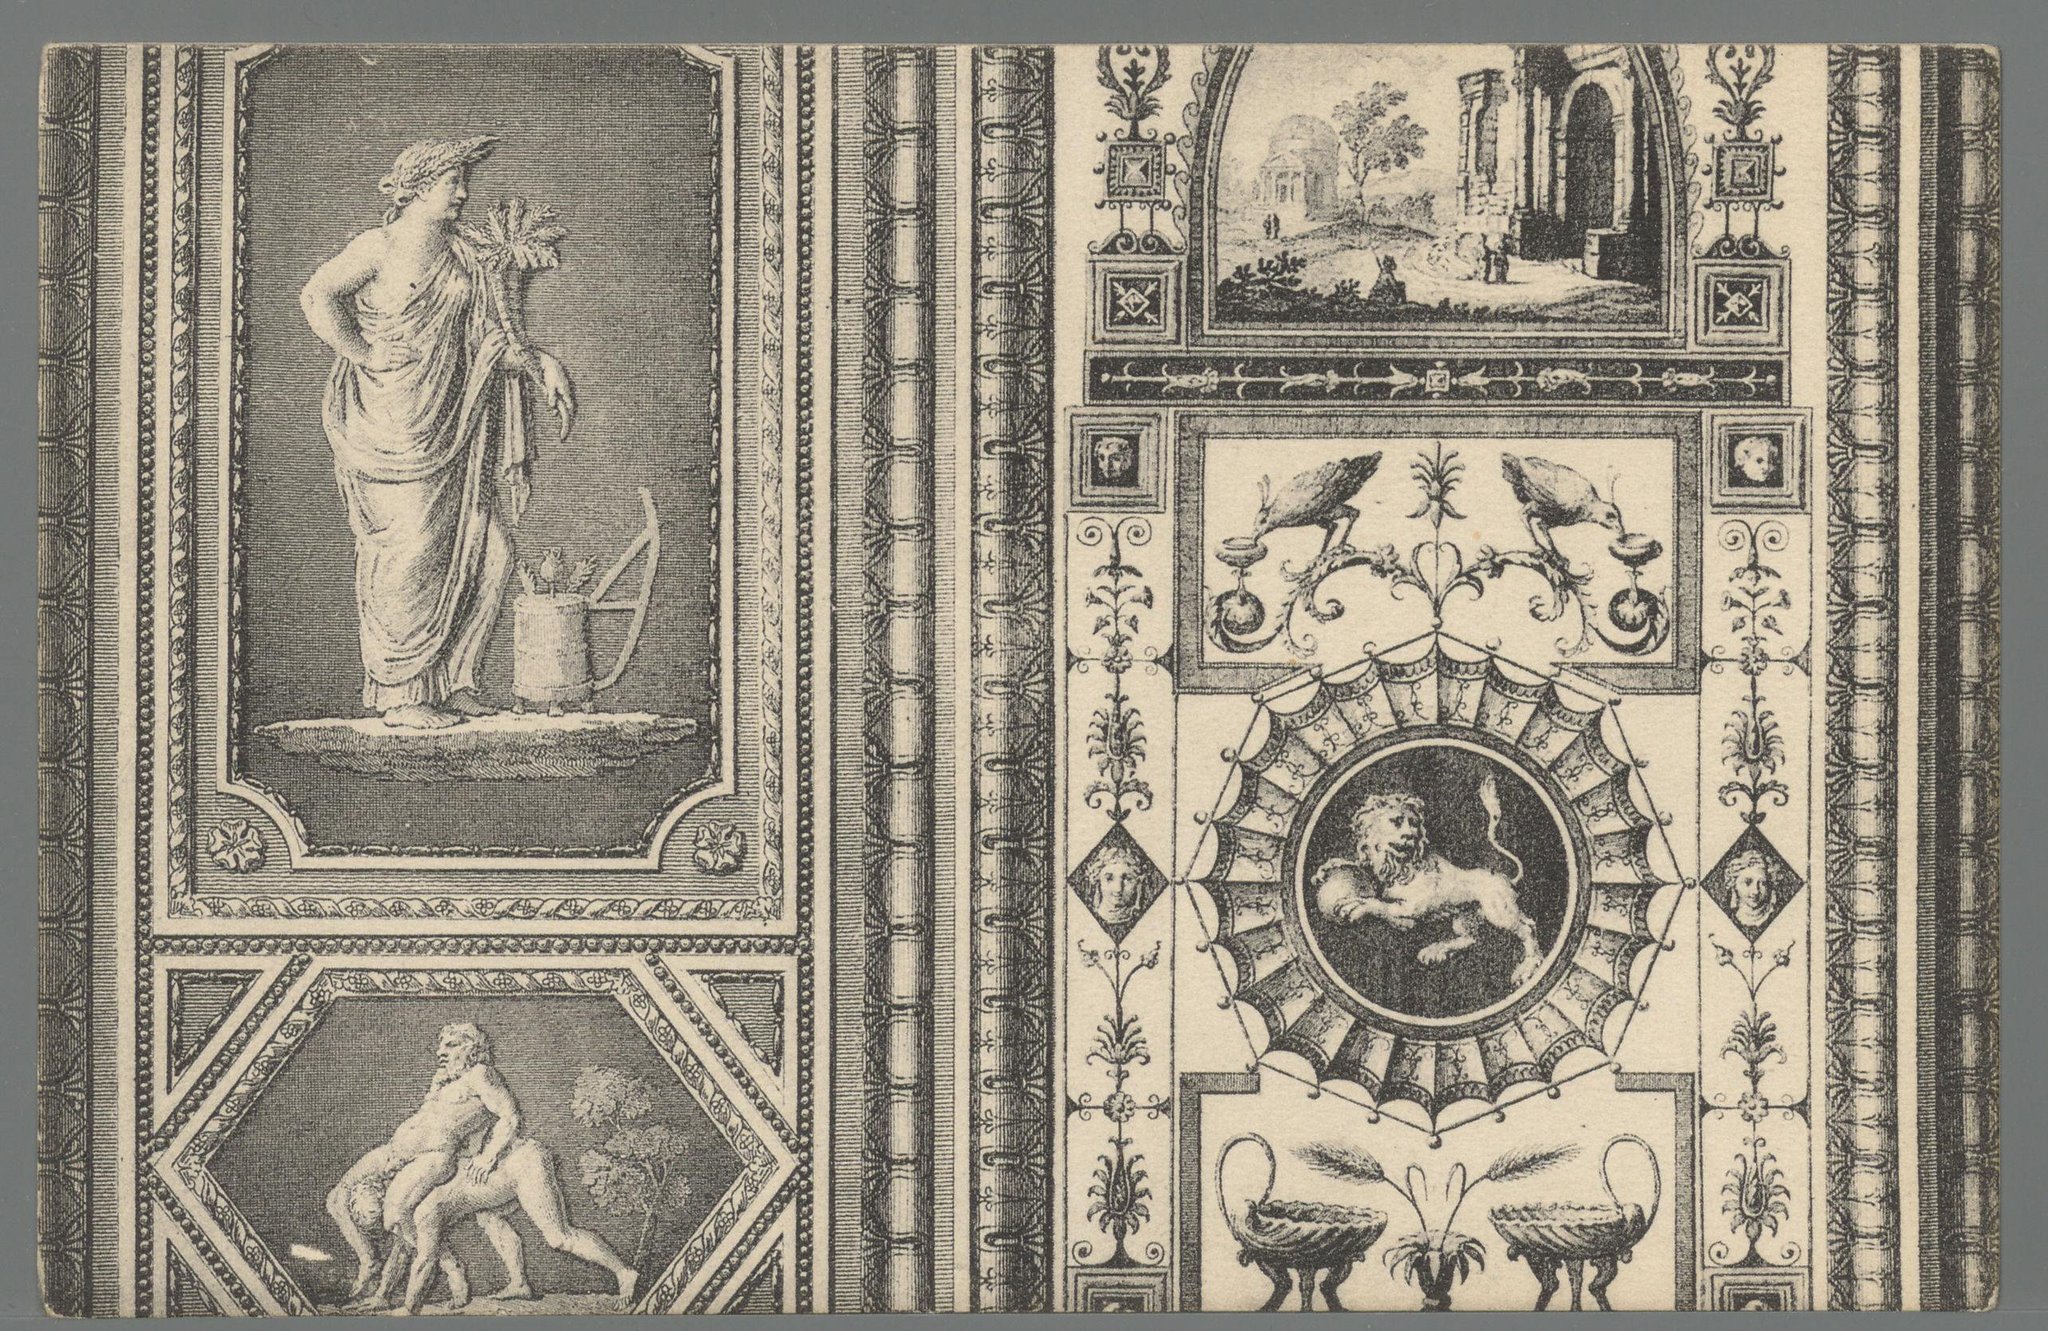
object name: ansichtkaart, prentbriefkaart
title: Roma. Loggie di Raffaello Sanzio nel Vaticano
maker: Anonymous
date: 1906-1920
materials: cardboard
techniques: photograph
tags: palace - aa - civic architecture: inside, decorations (interior of the house), picture, painting